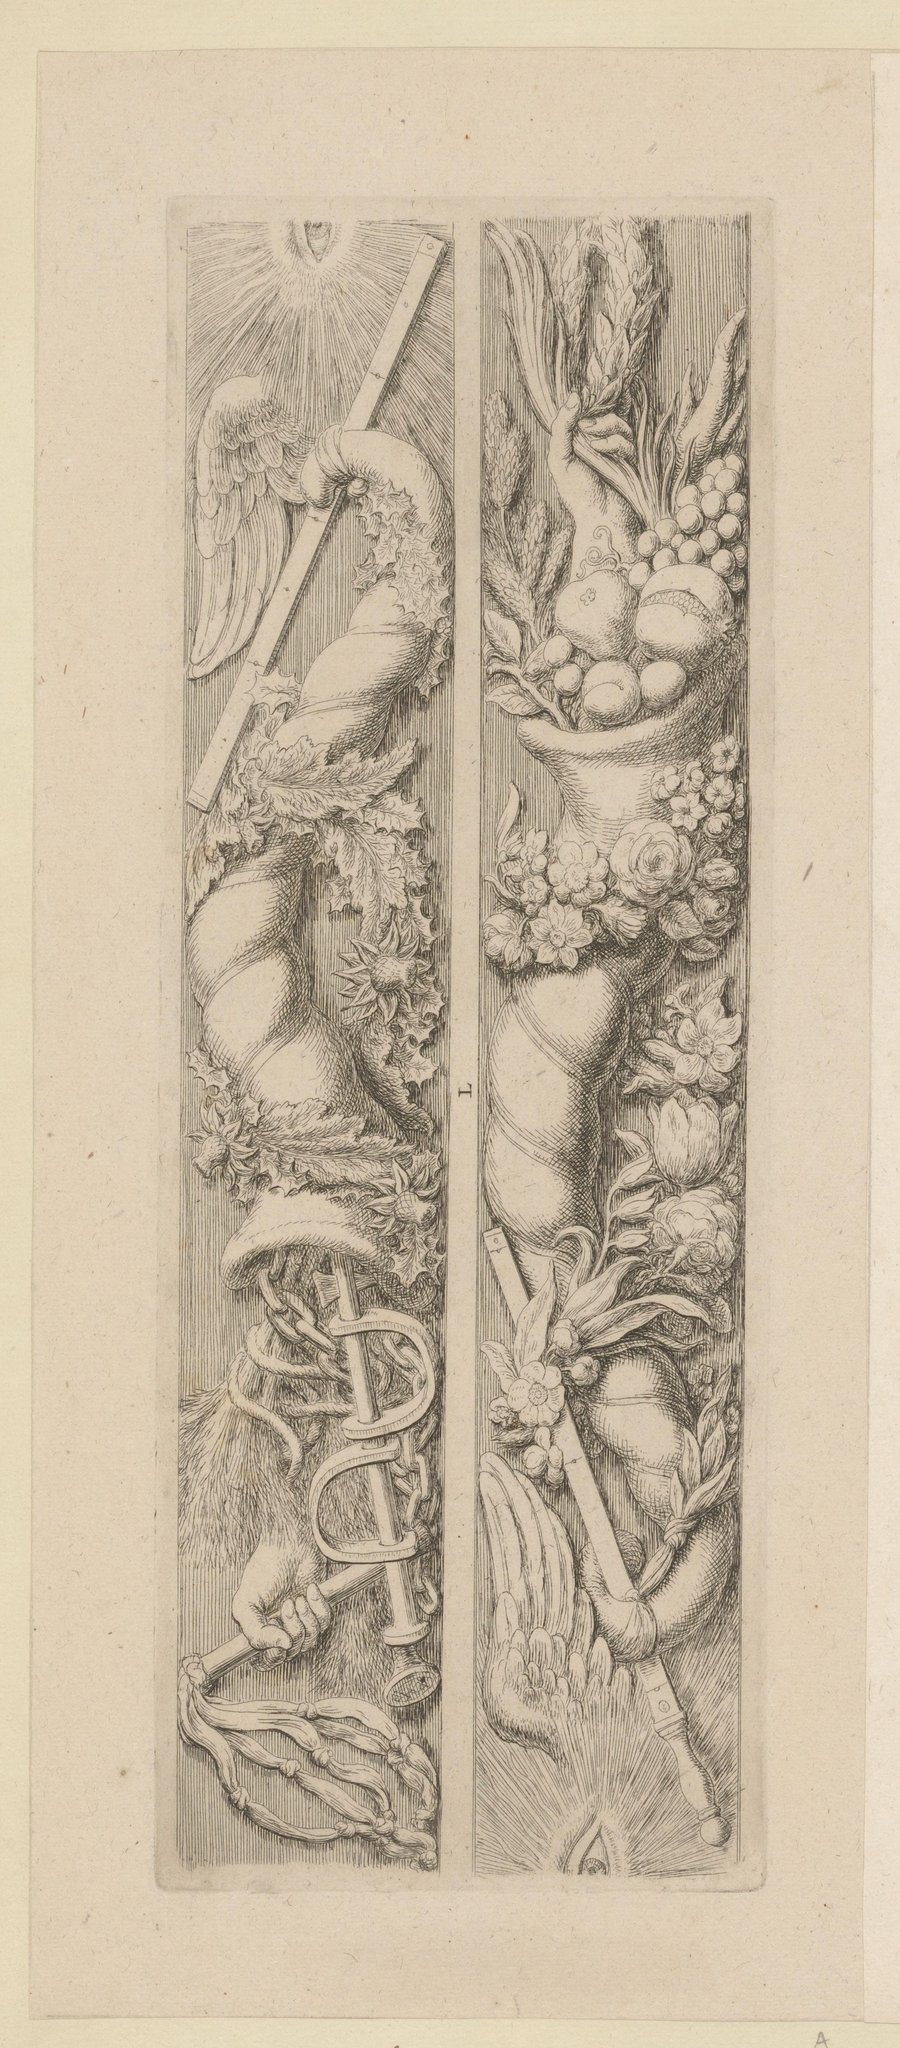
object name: print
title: Fries boven ingang van Schepenzaal aan westzijde van Burgerzaal in het Stadhuis op de Dam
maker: hubert quellinus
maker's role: print maker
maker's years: 1619-1687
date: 1663-1668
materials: paper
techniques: engraving, etching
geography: amsterdam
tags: measuring-instruments (with name), law and jurisprudence (+ handcuffs, fetters), townhall, the all-seeing eye, triangle with eye ~ symbol of god the father, criminal law; punishment, instruments of torture, execution or punishment, rewarding goodness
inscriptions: collector's mark: ‘16,78’ Lugt 1641b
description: Huidige staat van prent ook gebruikt in: Secunca pars Praecipuarum effigierum ac ornamentorum amplissime Curiae Amstelrodamensis maiori ex parte in cadido marmore effectorum per Artum Quellinium eiusdem Civitatis Statuarium / Het tweede deel Van de voornaemste Statuen ende Cieraten van 't konst-rijcke Stadt-huys van Amstelredam 'tmeeste in Marmer gemaeckt door Artus Quellinus Beelthouwer der voorseyde Stadt. Amsterdam: Artus Quellinus (I), 1663. En in: Secunca pars Praecipuarum effigierum ac ornamentorum amplissime Curiae Amstelrodamensis maiori ex parte in cadido marmore effectorum per Artum Quellinium eiusdem Civitatis Statuarium / Het tweede deel Van de voornaemste Statuen ende Cieraten van 't konst-rijcke Stadt-huys van Amstelredam 'tmeeste in Marmer gemaeckt door Artus Quellinus Beelthouwer der voorseyde Stadt. Amsterdam: Frederik de Wit, 1668. Latere staat van prent ook gebruikt in: Architecture peinture et sculpture de la Maison de Ville d'Amsterdam, representee en CIX. figures en taille-douce (…). Amsterdam: David Mortier, 1719. En in: Architecture peinture et sculpture de la Maison de Ville d'Amsterdam, representee en CIX. figures en taille-douce (…). Amsterdam: Gerard Valck, 1719. En in: Bouw schilder en beeldhouwkonst, van het Stadhuis te Amsteldam, vertoont in CIX figuuren (…). Amsterdam: Covens & Mortier & Covens Jr., s.a. (1774-1783).